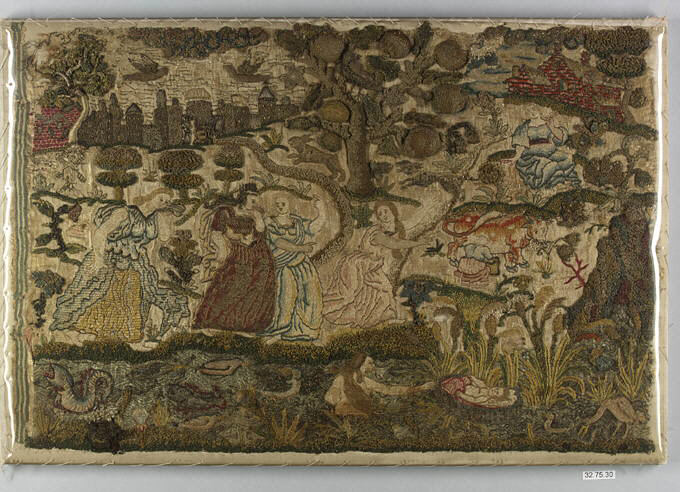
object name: panel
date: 1651-1675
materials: metal thread, silk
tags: birds,women,fish,trees